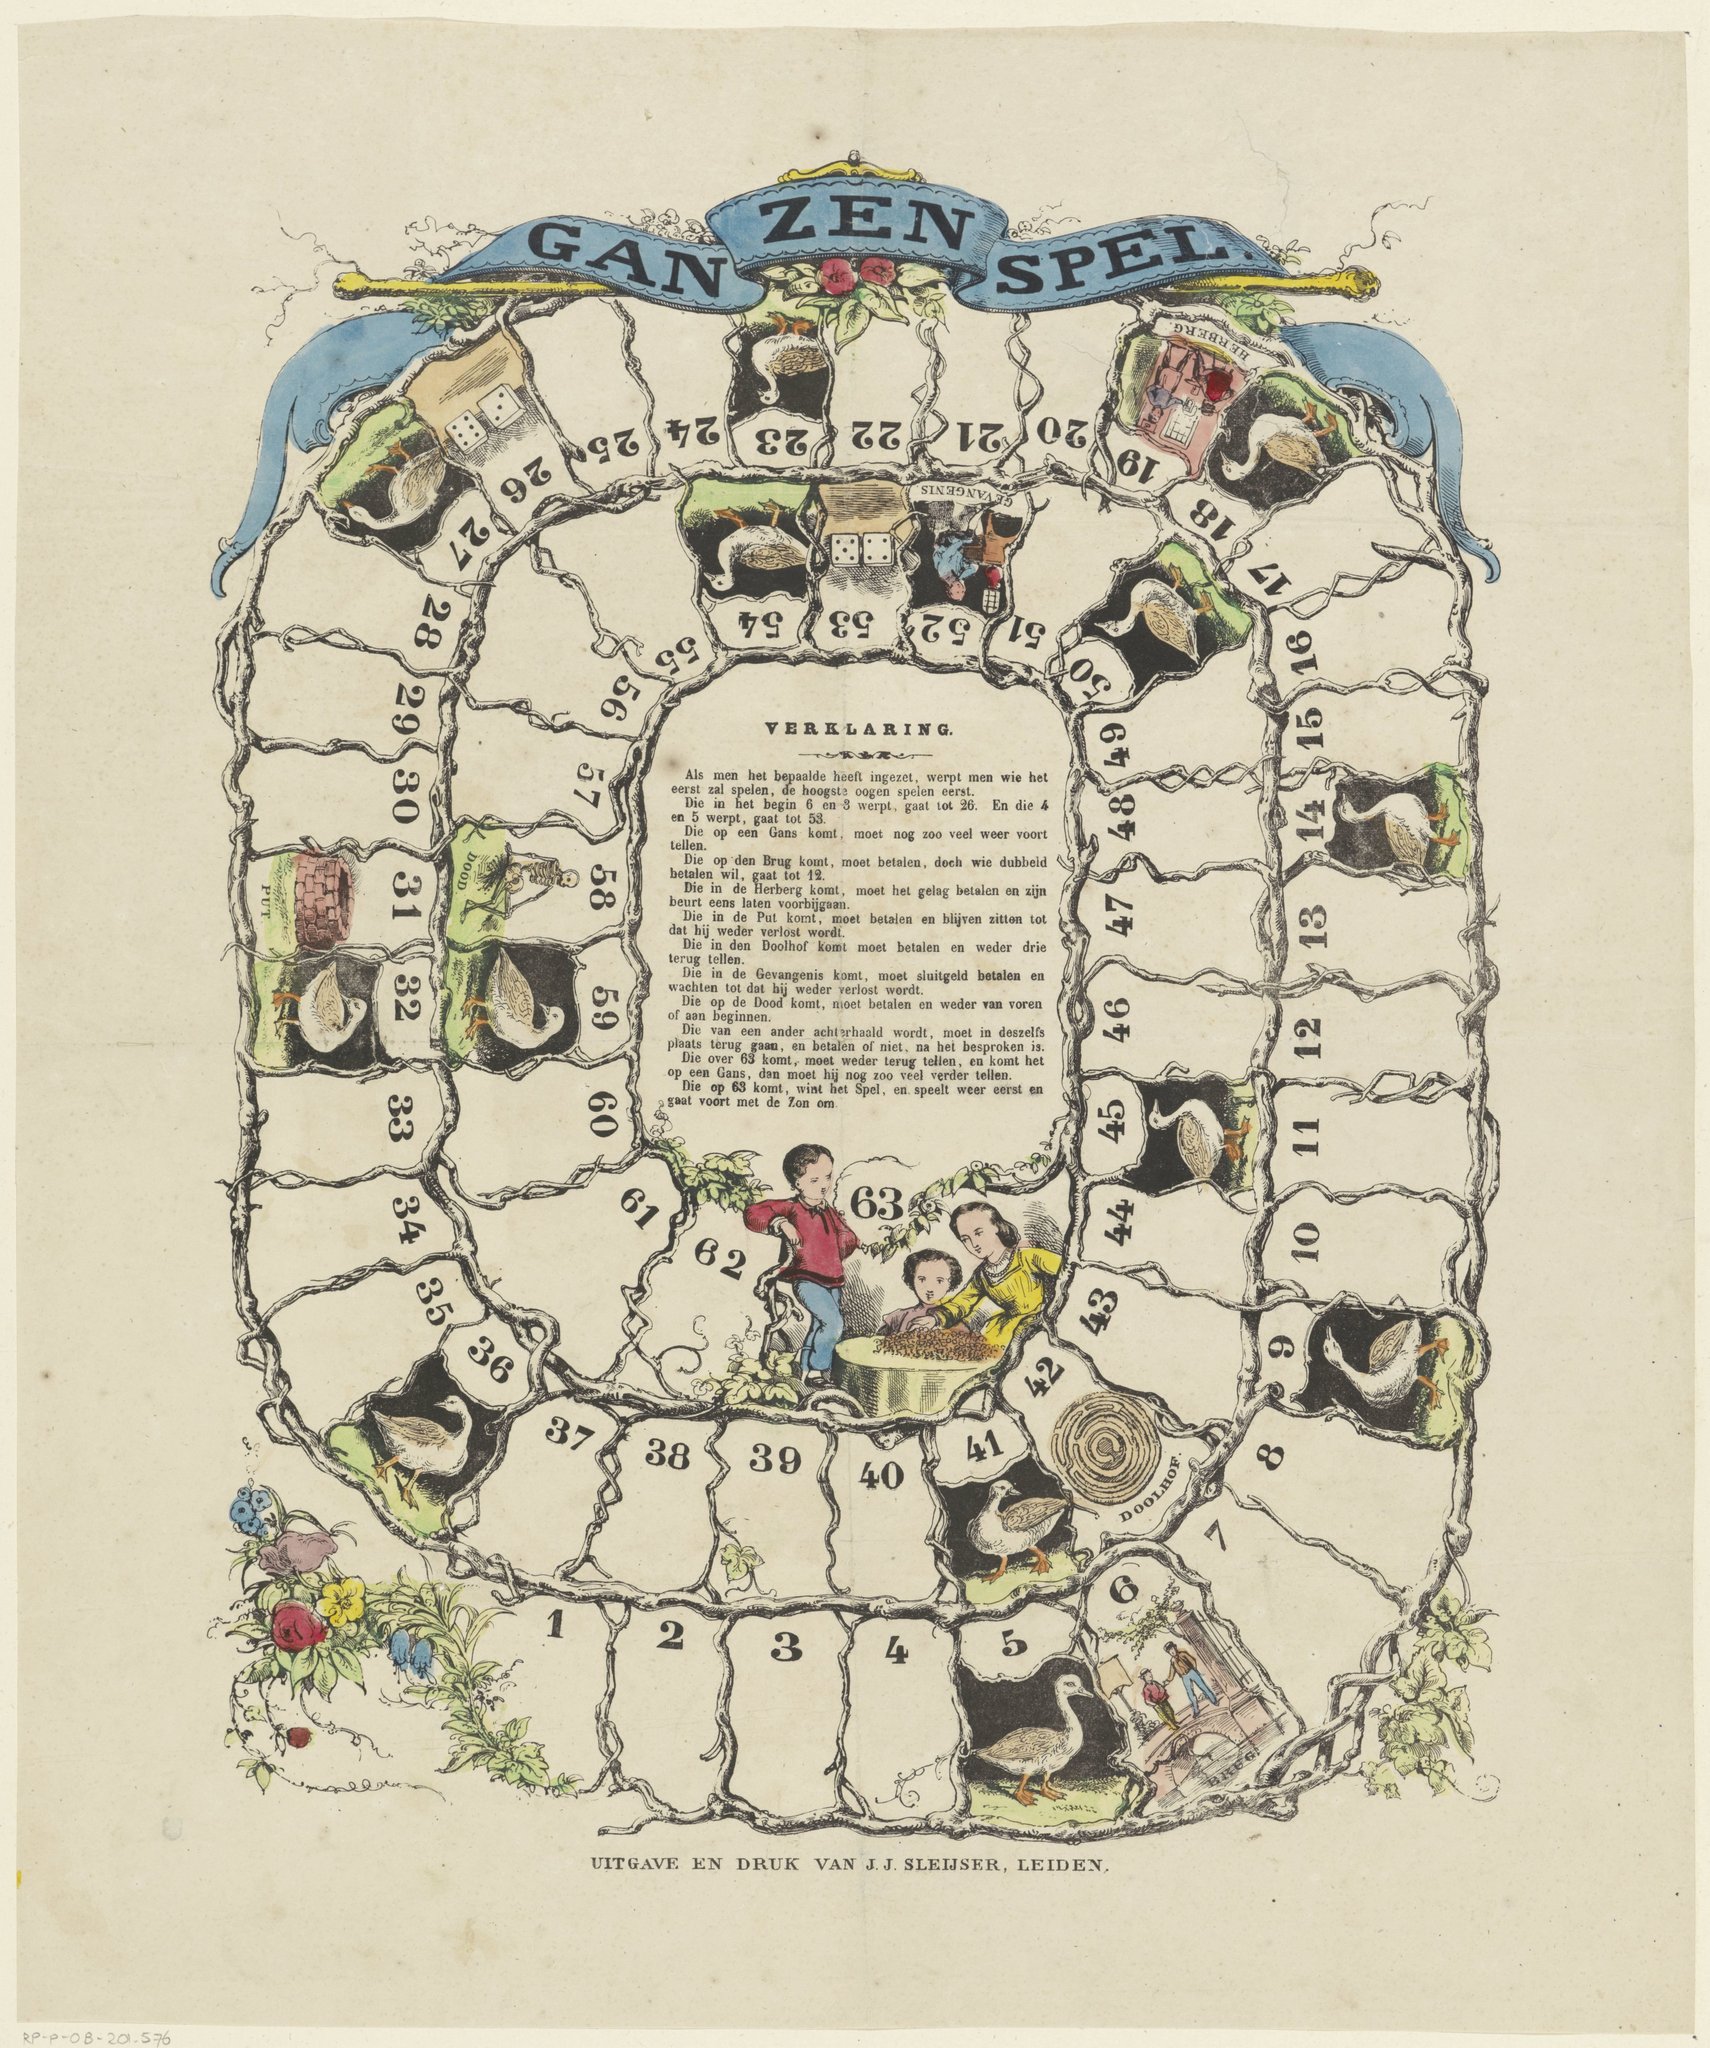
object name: popular print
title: Ganzenspel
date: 1870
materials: paper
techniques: colour, letterpress printing, lithograph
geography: leiden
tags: goose-game, board-games of chance, board-games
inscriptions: collector's mark: Lugt 2760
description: Ganzenbordspel met een spiraal met 63 genummerde vakjes. Op het middenveld de spelregels. In verschillende vakjes een voorstelling van een gans. Midden boven de titel op een banderol.